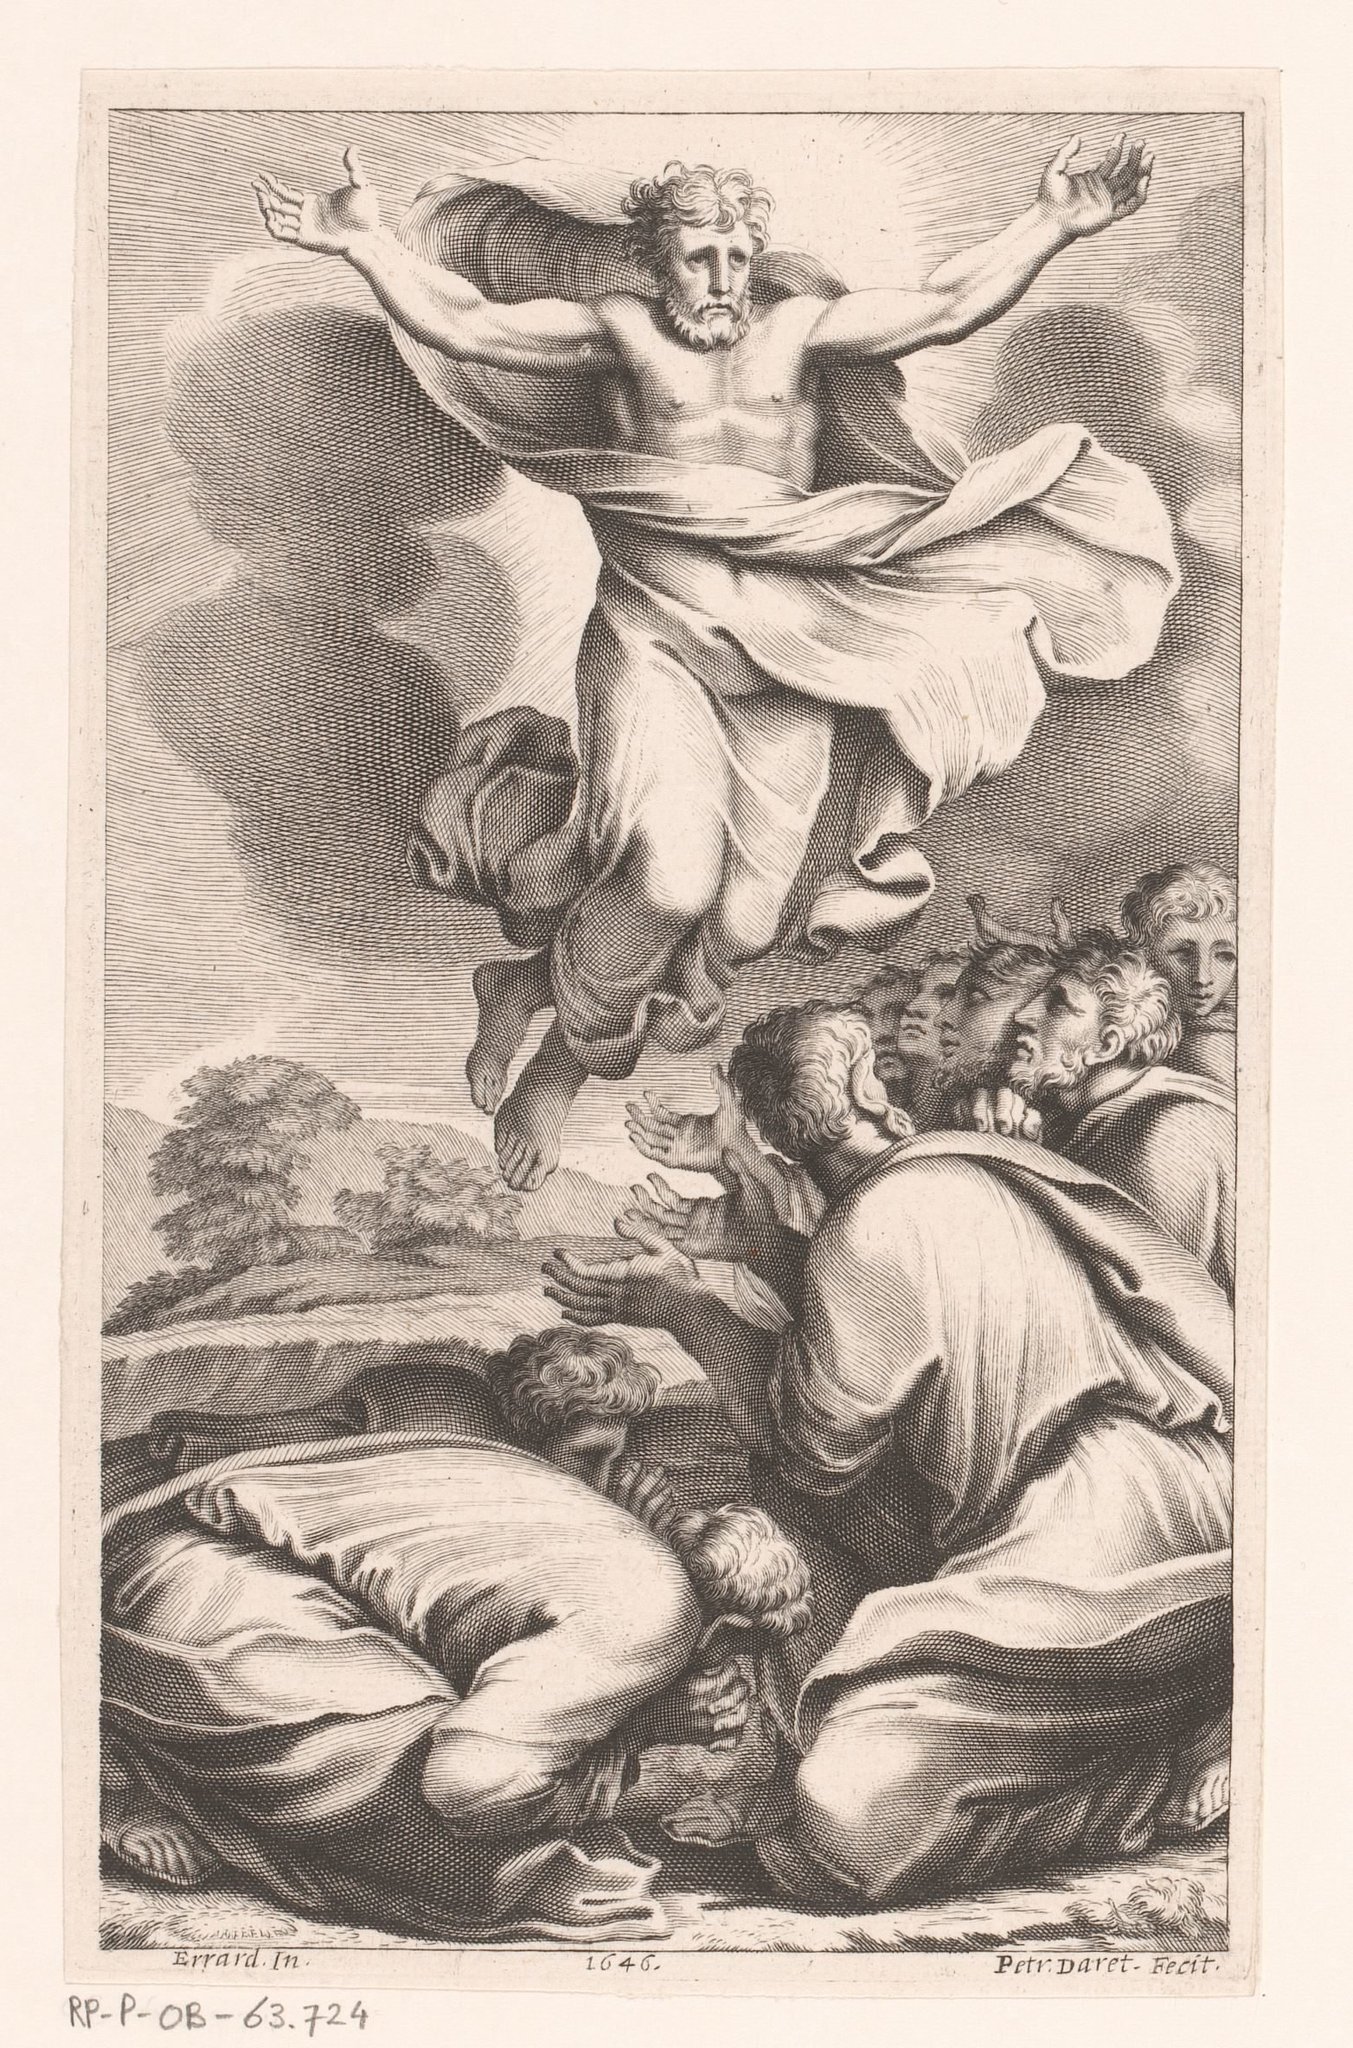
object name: print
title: Scènes uit het leven van Christus en de Maagd Maria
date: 1646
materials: paper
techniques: engraving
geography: paris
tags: the ascension (christ surrounded by radiant light or in a mandorla)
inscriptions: collector's mark: Lugt 2228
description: Maakt deel uit van een zevendelige serie met scènes uit het leven van Christus en de Maagd Maria.